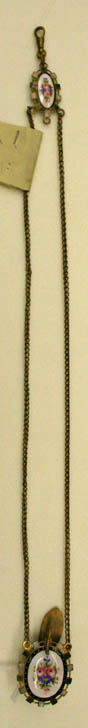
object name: chatelaine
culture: american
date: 1890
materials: enamel